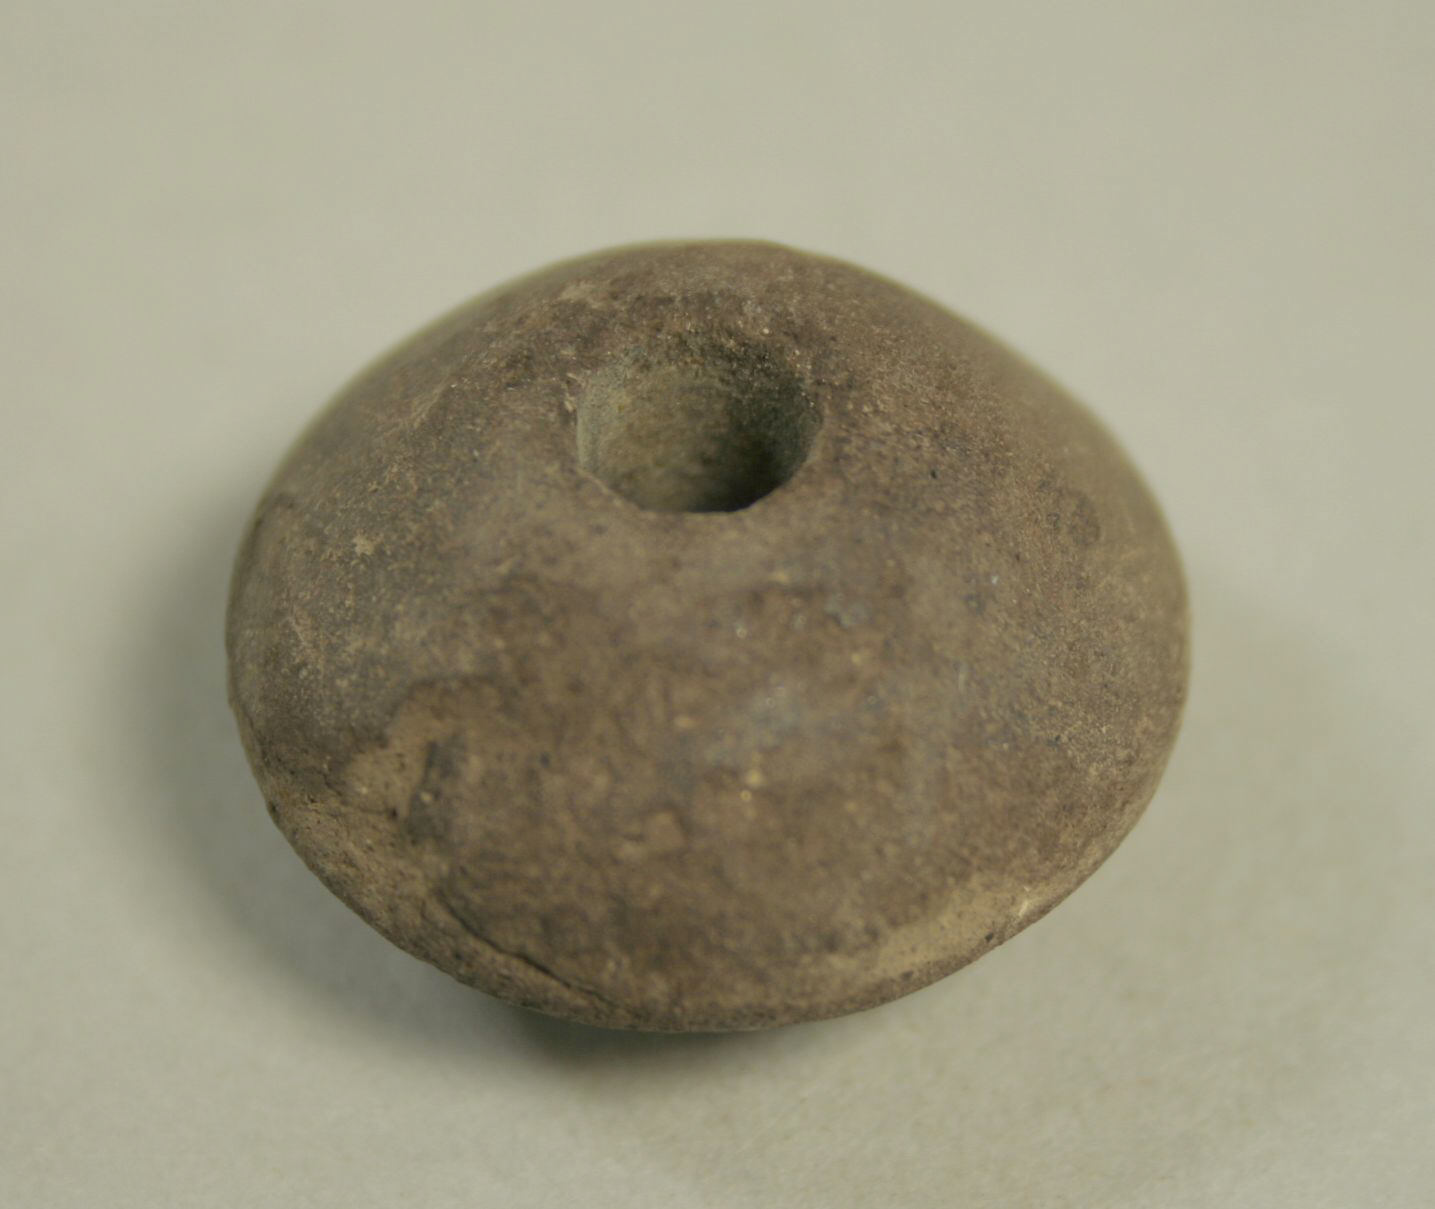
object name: spindle whorl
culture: peruvian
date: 901-1600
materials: ceramic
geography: peru